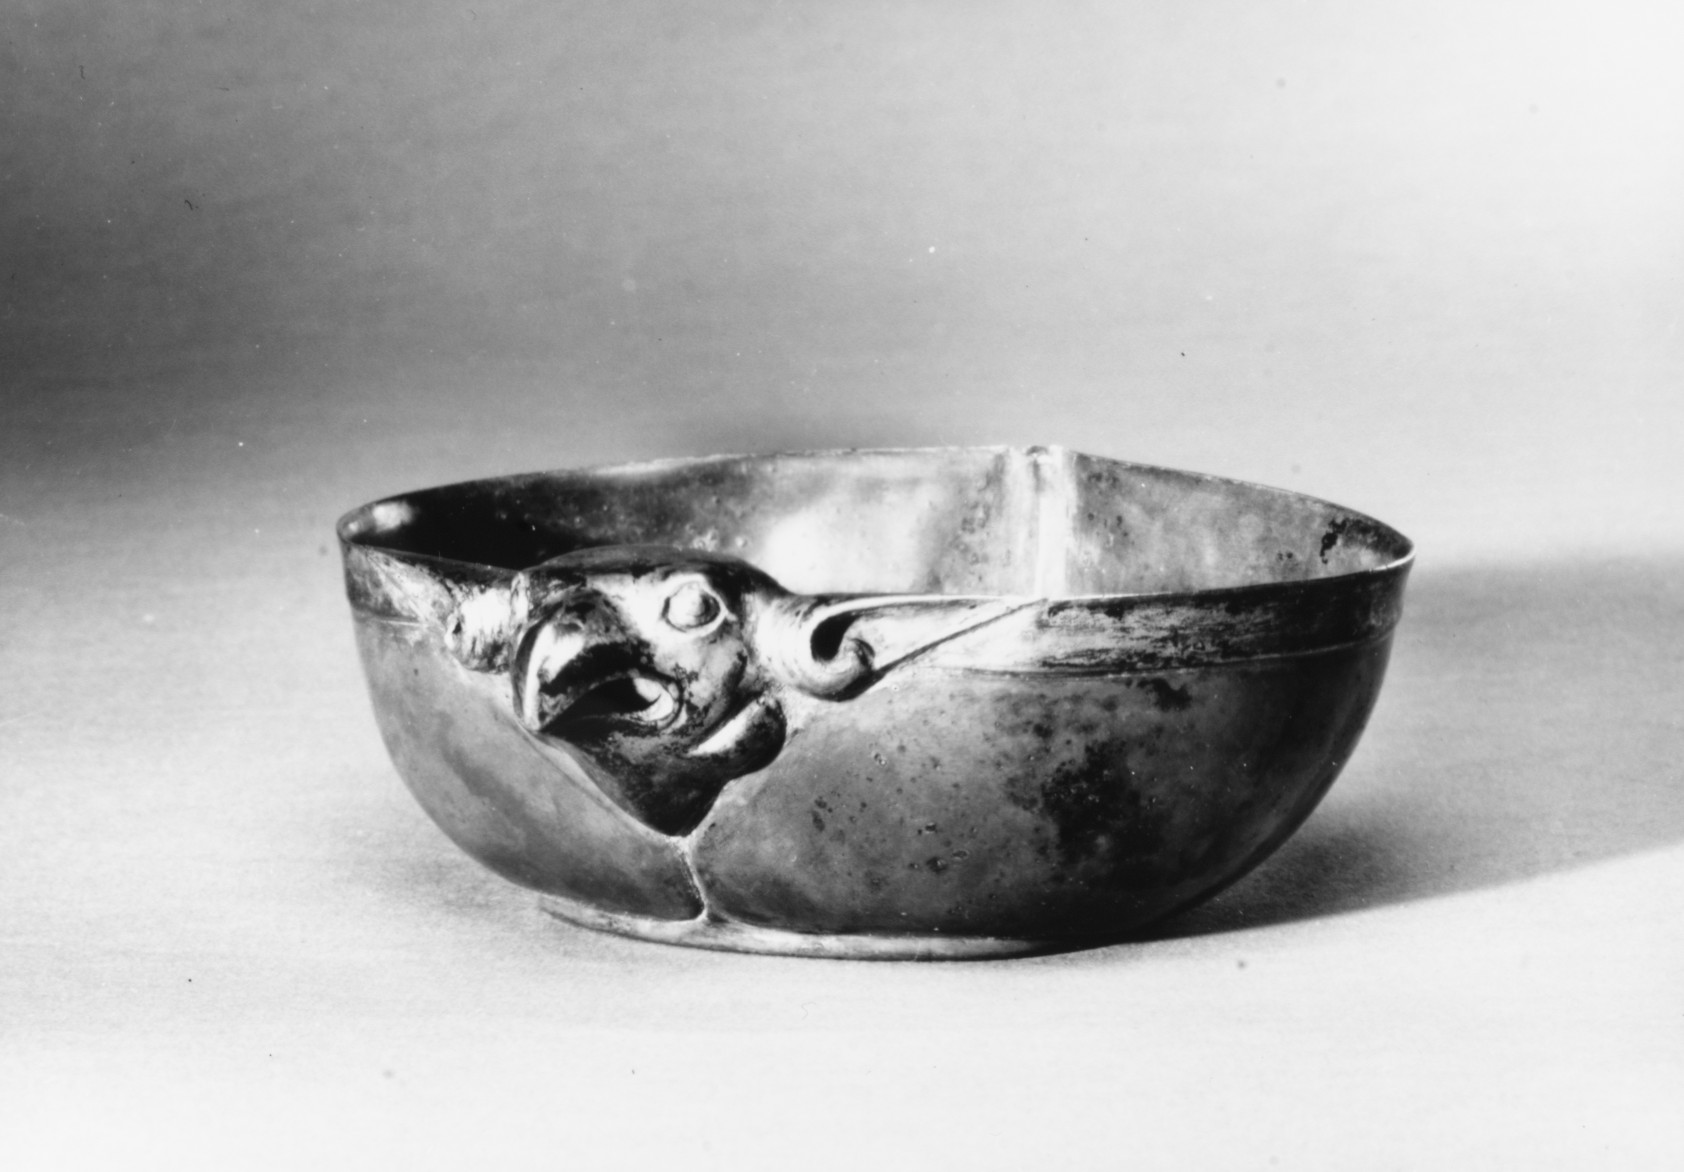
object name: cup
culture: chinese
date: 500-201 BCE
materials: silver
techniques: gilding